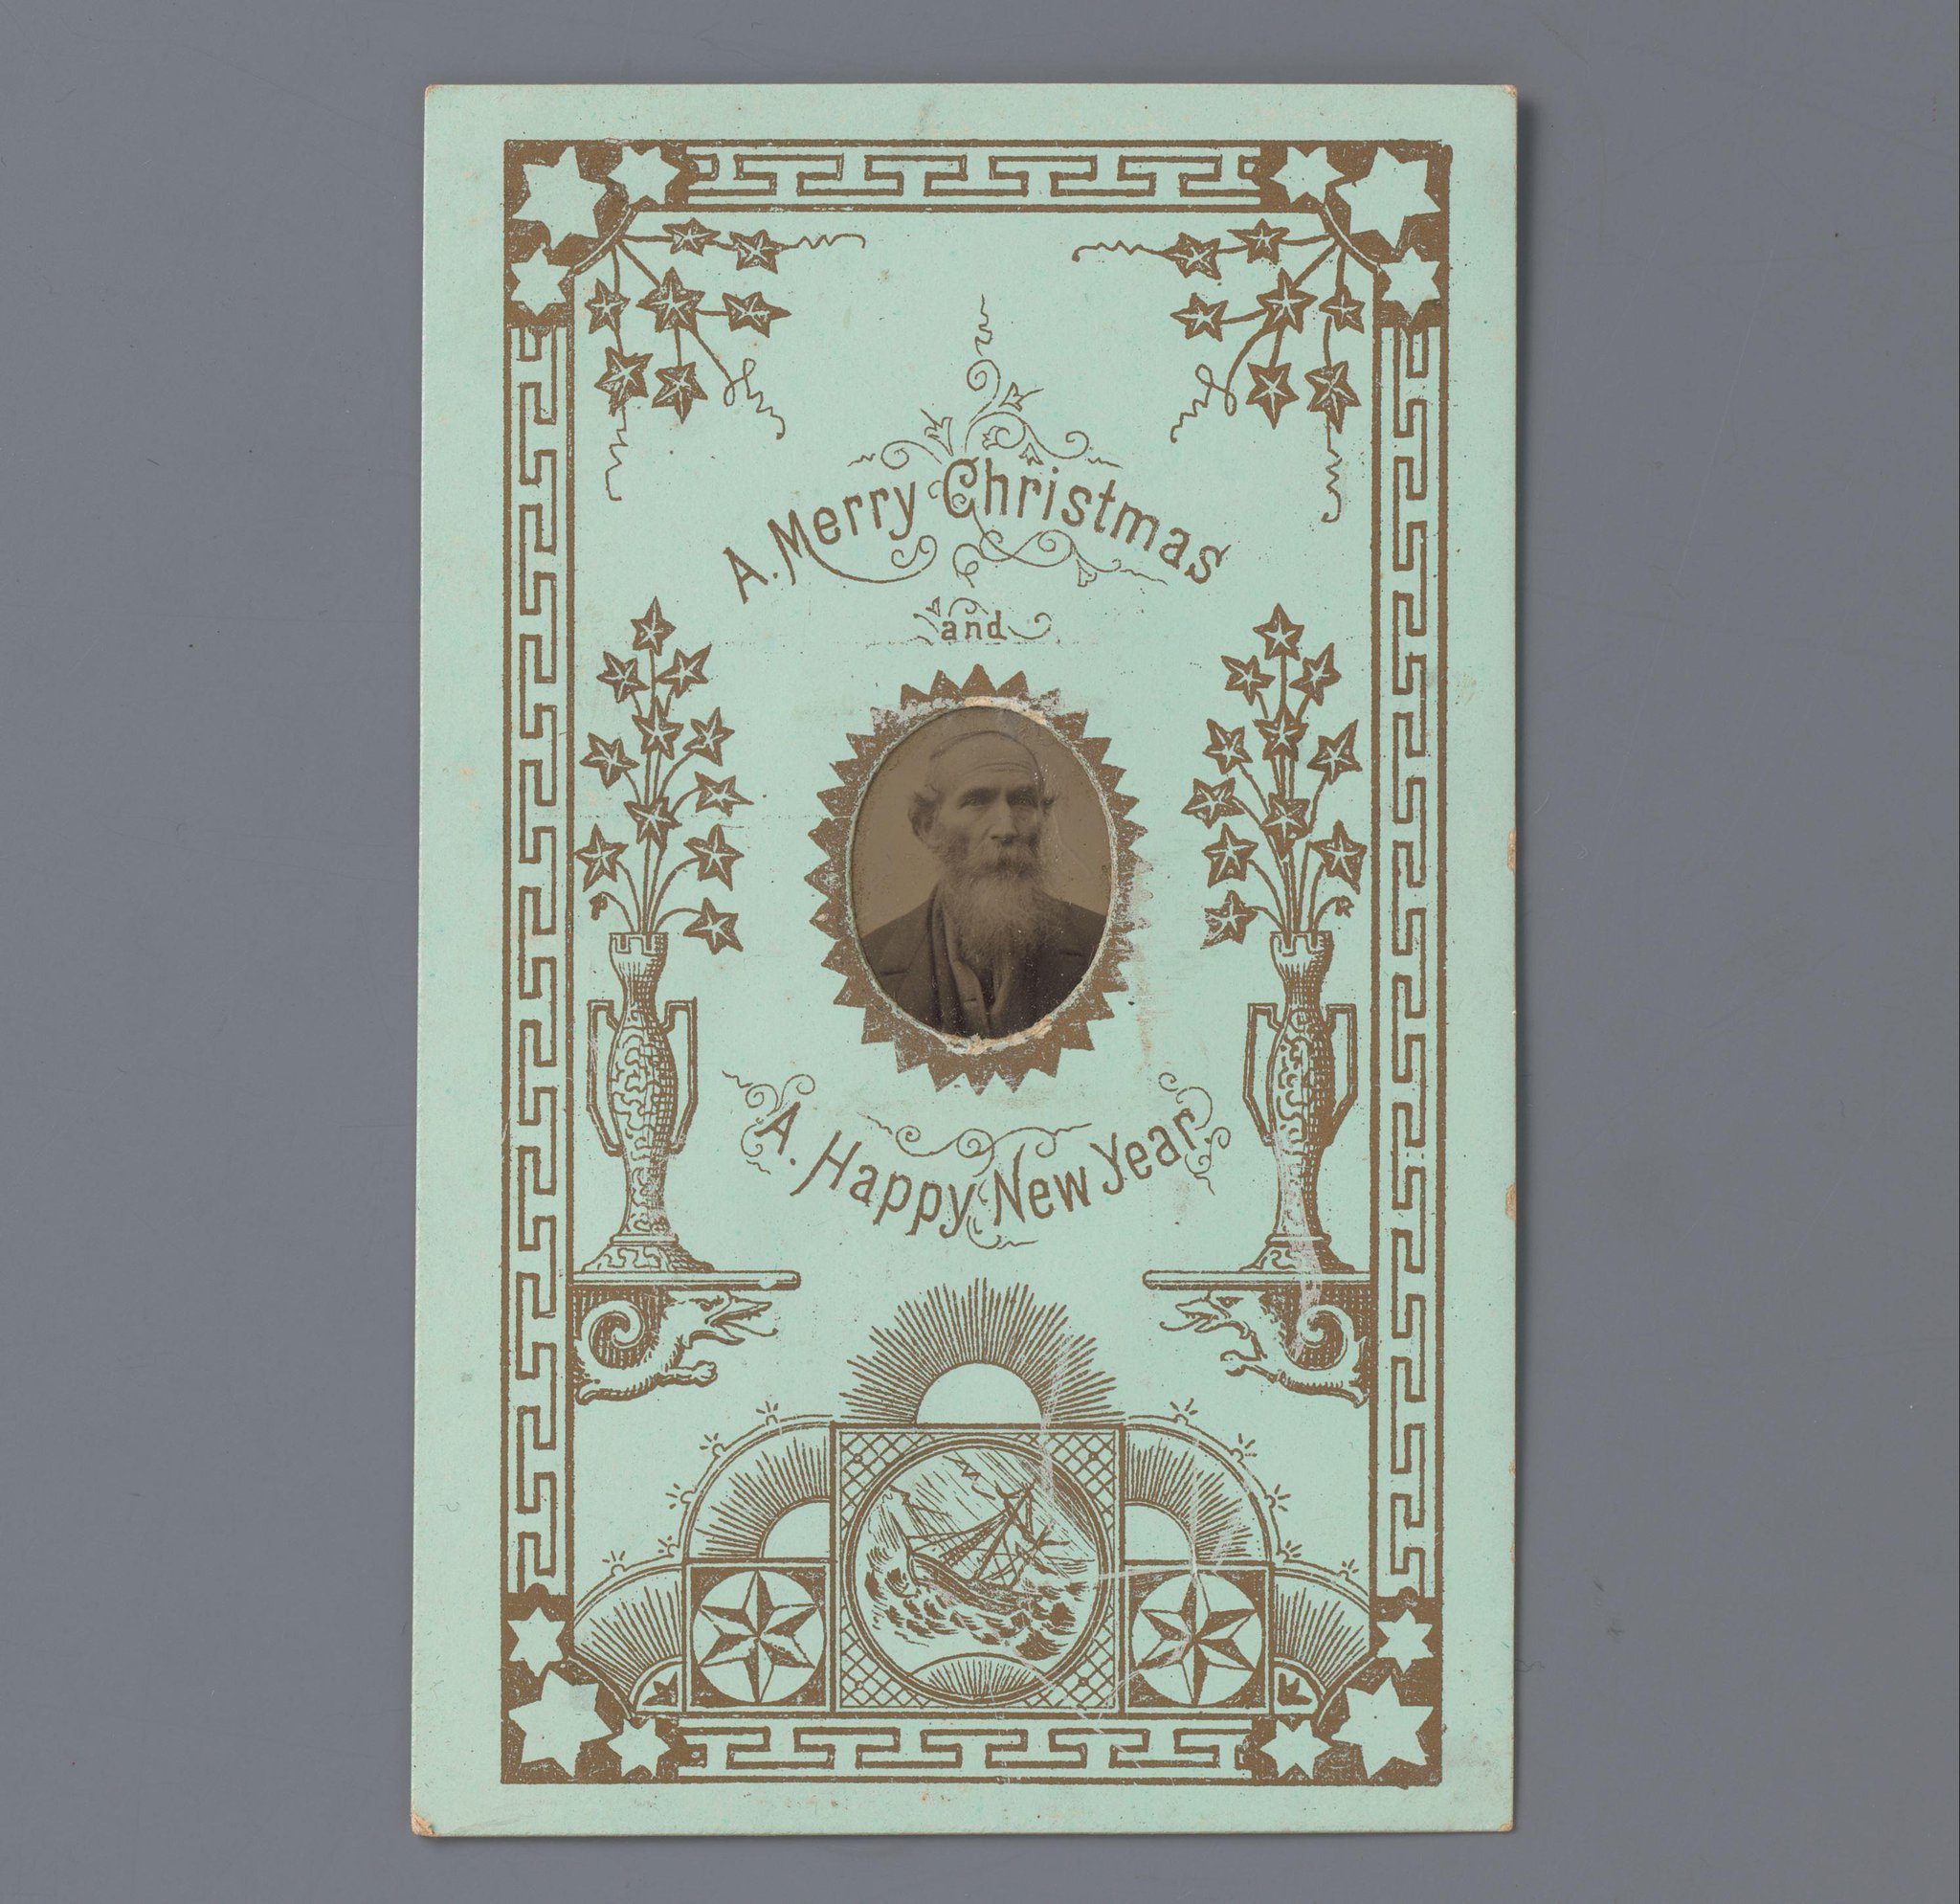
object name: photograph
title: A Merry Christmas and A Happy New Year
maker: london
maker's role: fotograaf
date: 1855-1900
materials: cardboard, iron, paper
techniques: ferrotyping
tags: historical persons, old man, beard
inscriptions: inscription: ‘LONDON & BRISTOL PHOTOGRAPHY/ COMPANY./ LATEST NOVELTY,/ 12 GEMS FOR 7 1/2 d./ 5, CLARESTREET,/ BRISTOL,/ NEXT THE AUCTION ROOMS.’